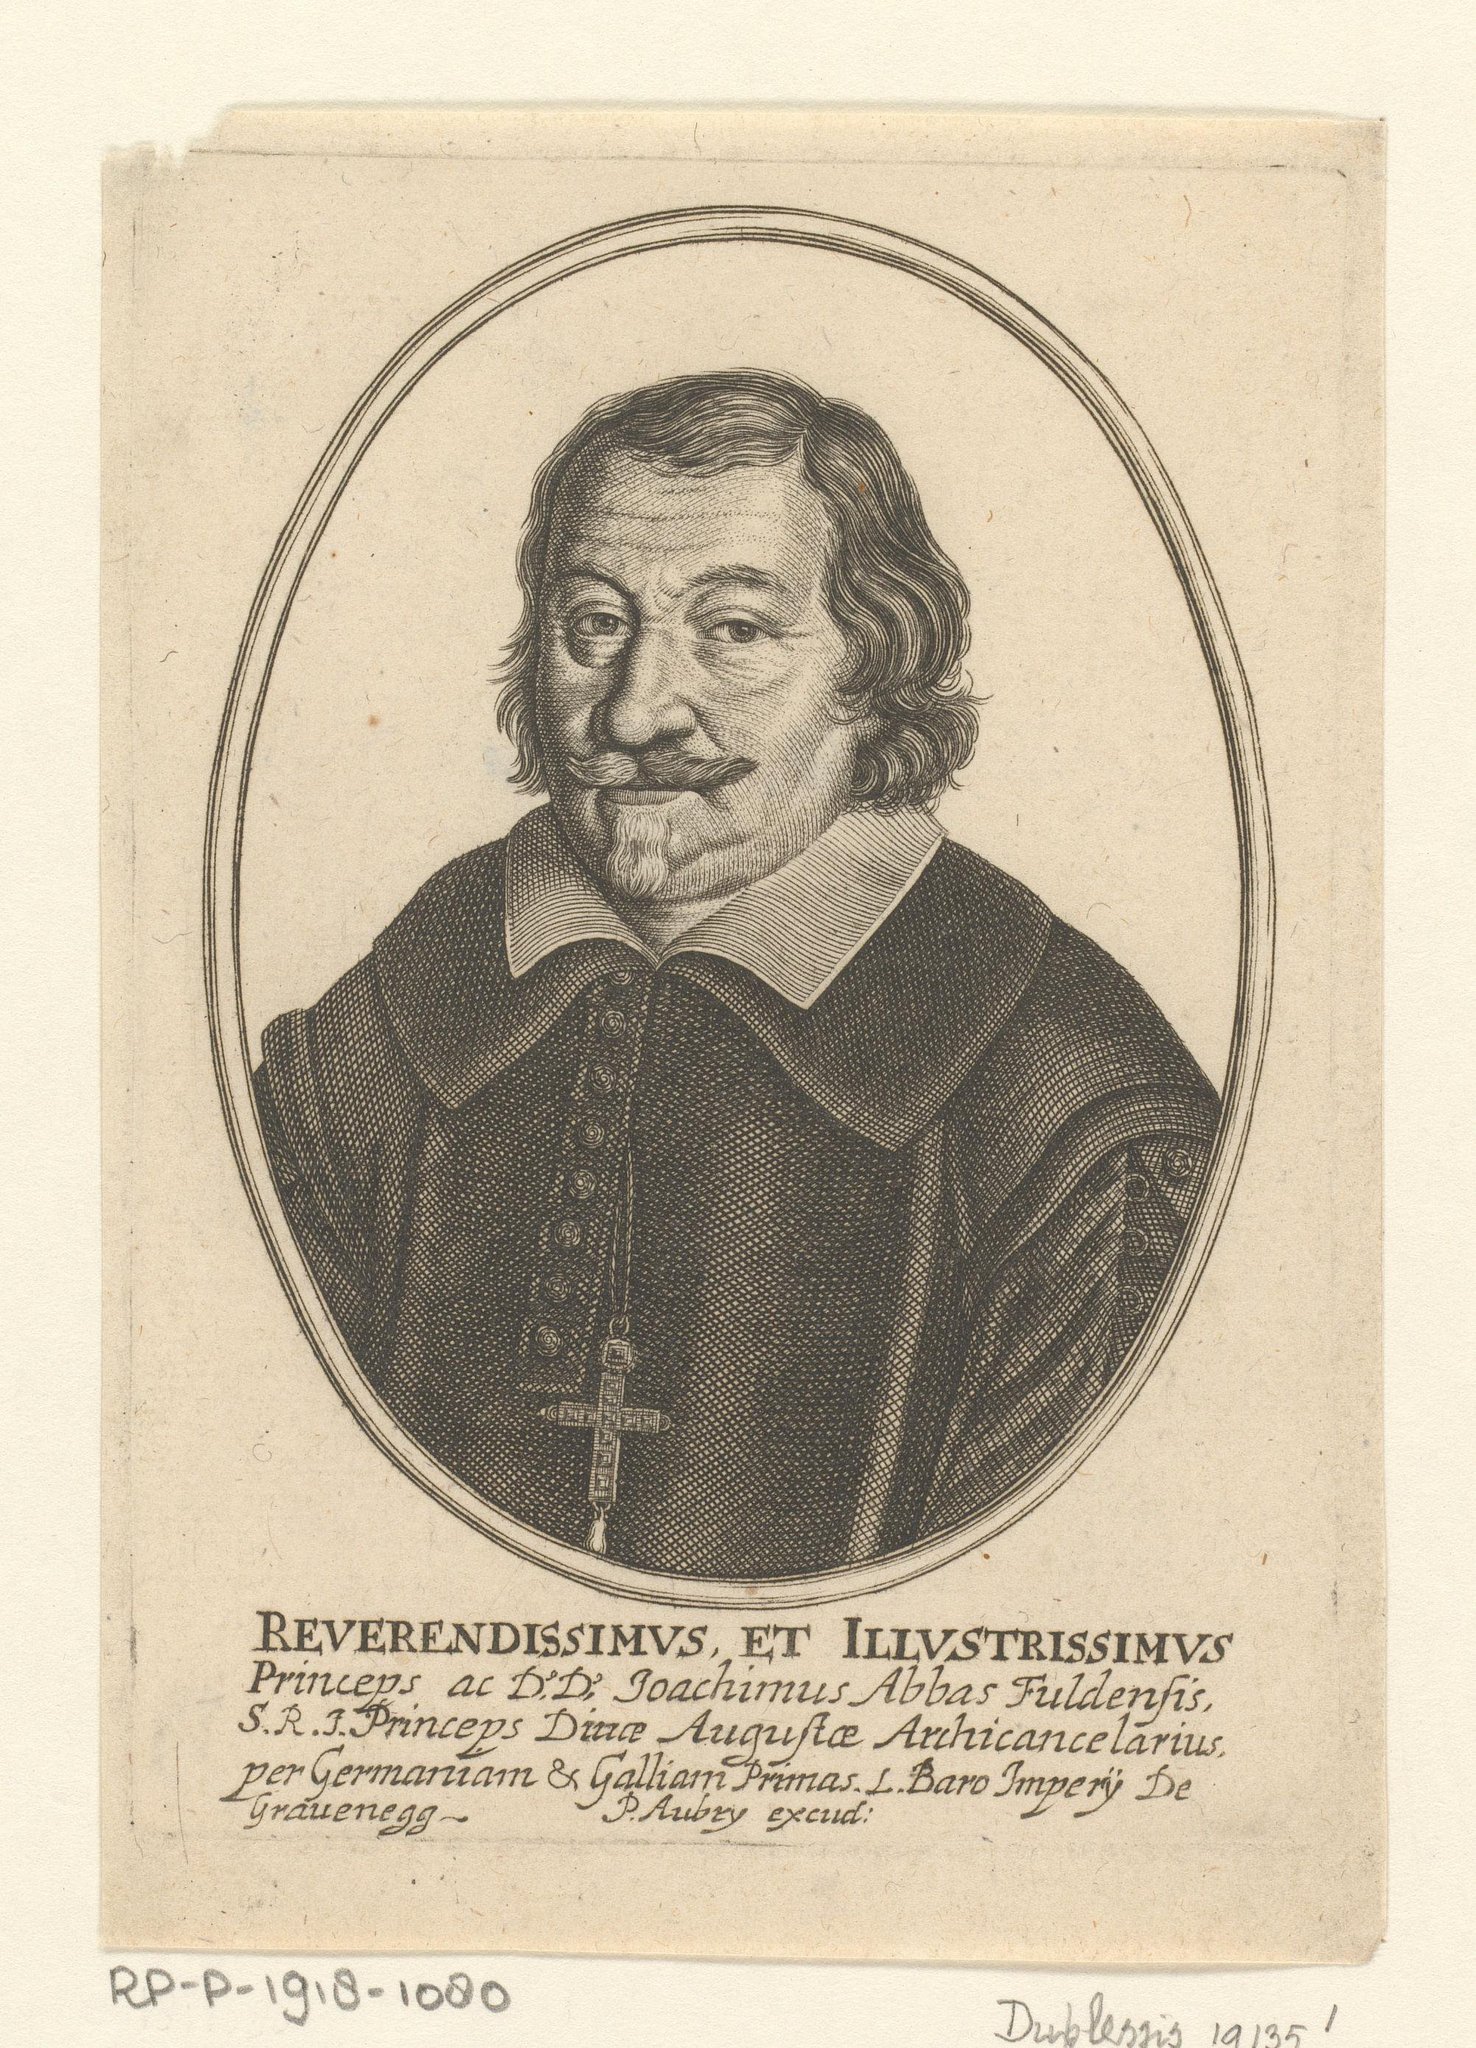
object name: print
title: Portret van Joachim von Gravenegg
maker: Anonymous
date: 1644-1686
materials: paper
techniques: engraving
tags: historical persons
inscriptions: collector's mark: Lugt 2233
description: Met vijfregelig onderschrift in het Latijn.